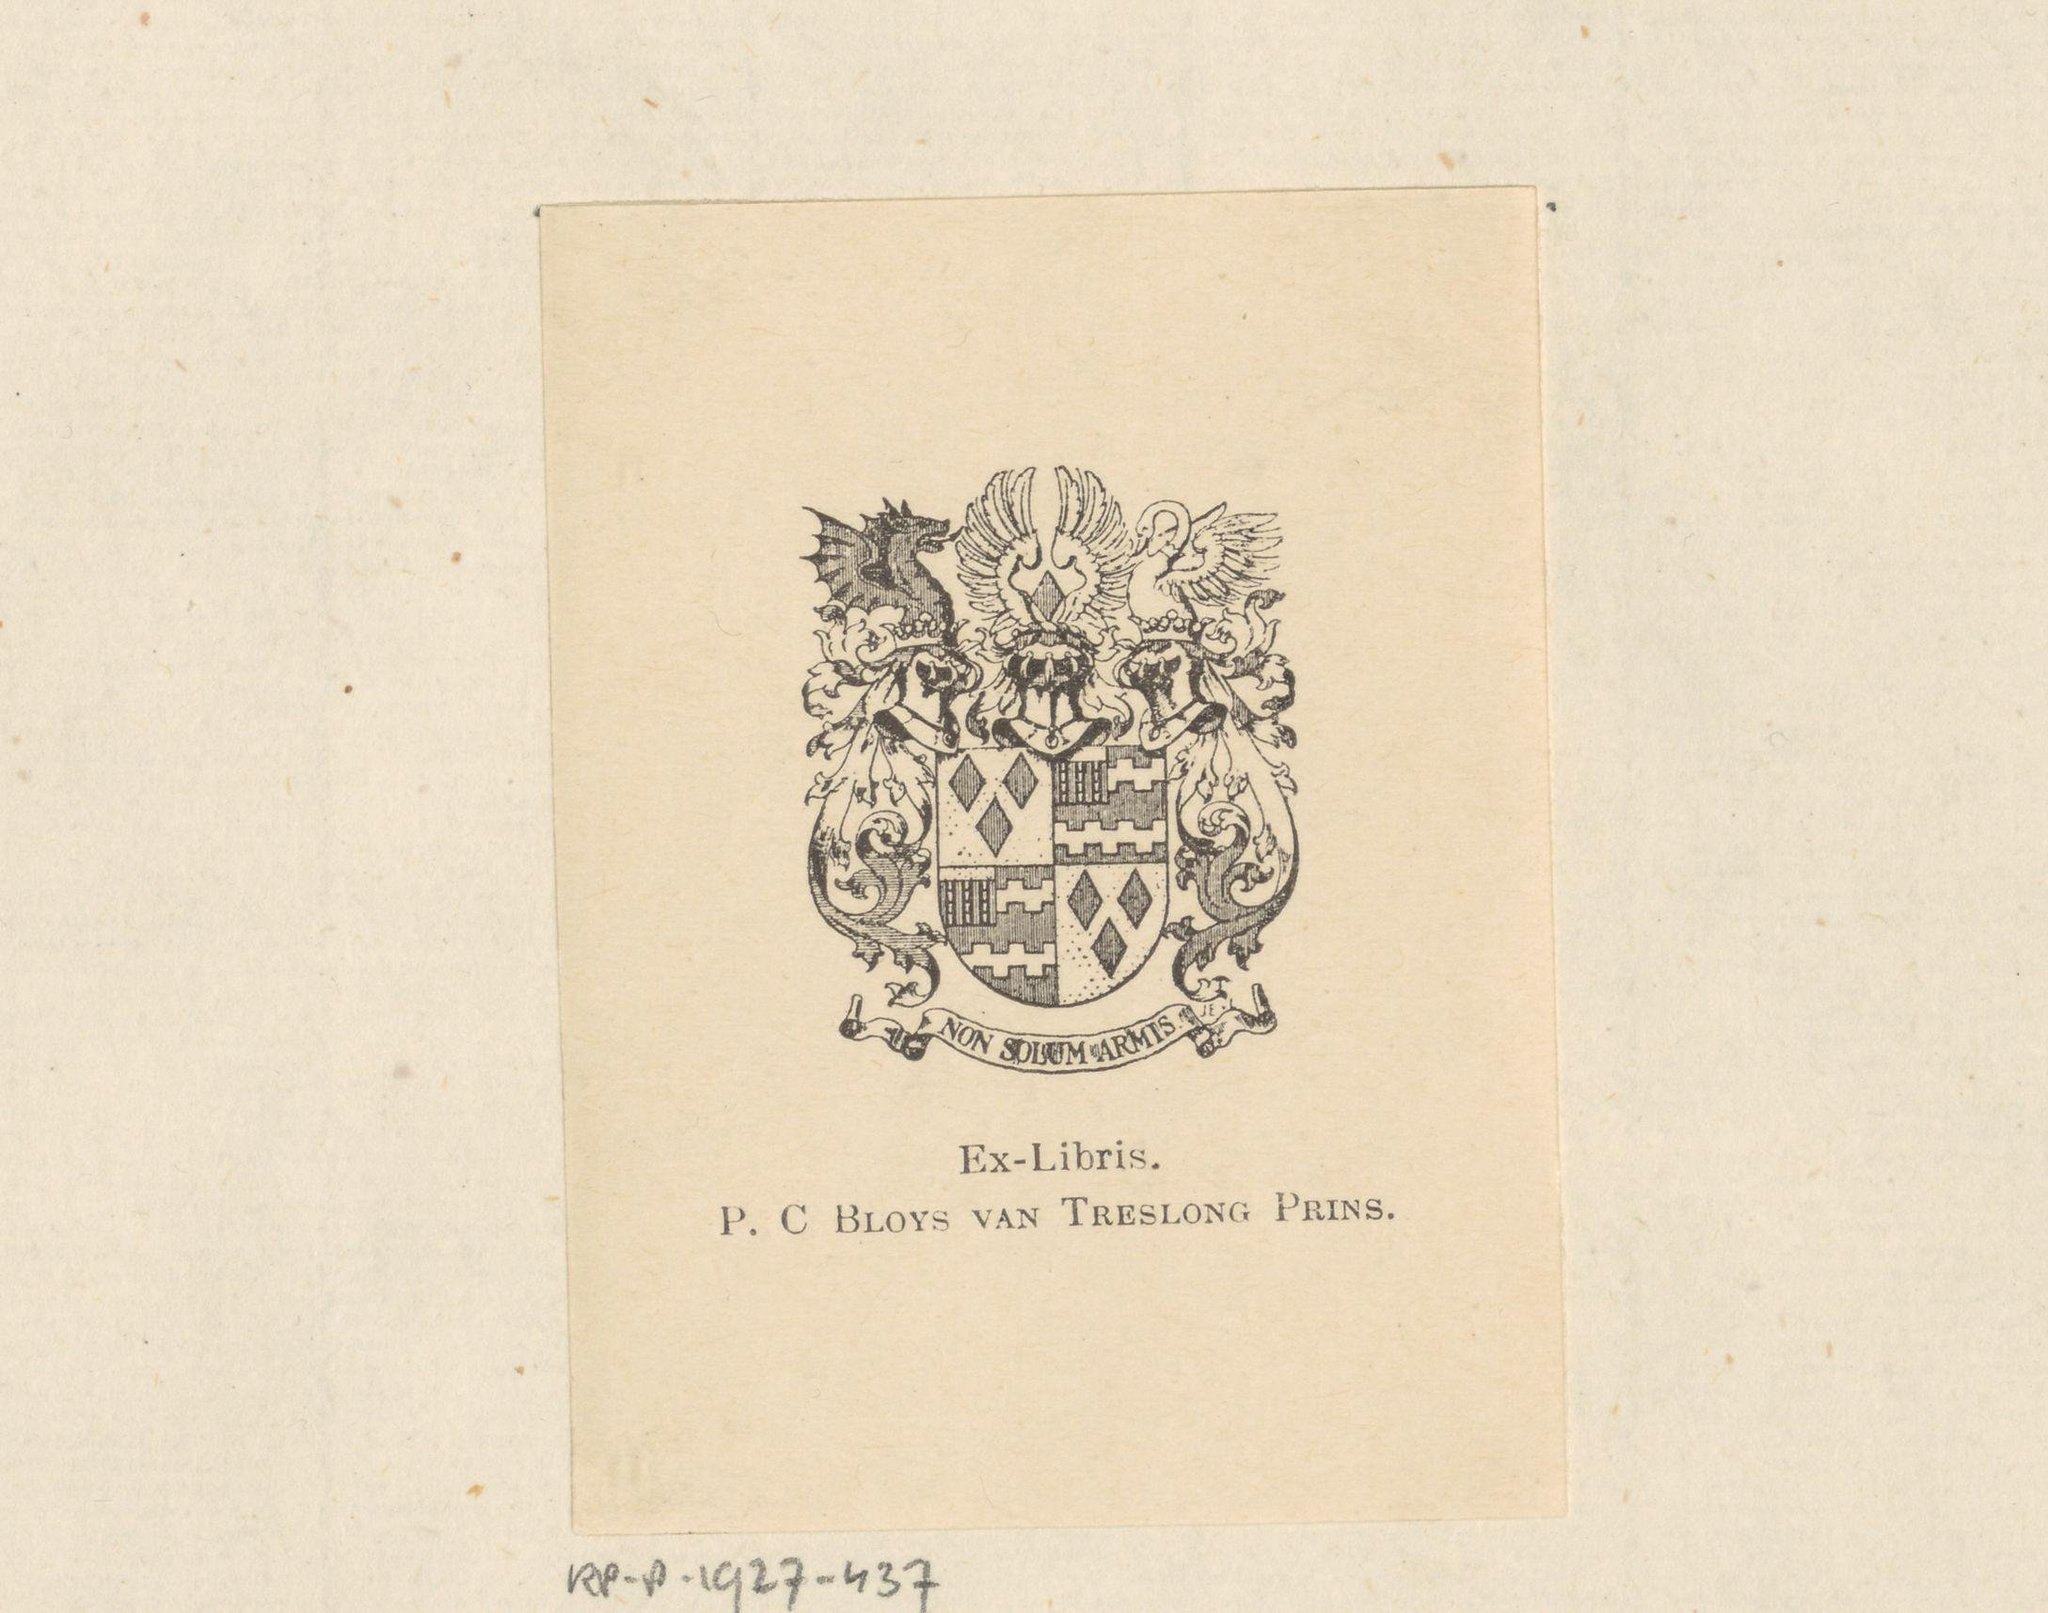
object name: bookplate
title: Ex libris van P.C. Bloys van Treslong Prins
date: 1883-1927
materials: paper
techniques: printing block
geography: netherlands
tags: delft, batavia, water-birds: swan, dragon, armorial bearing, heraldry